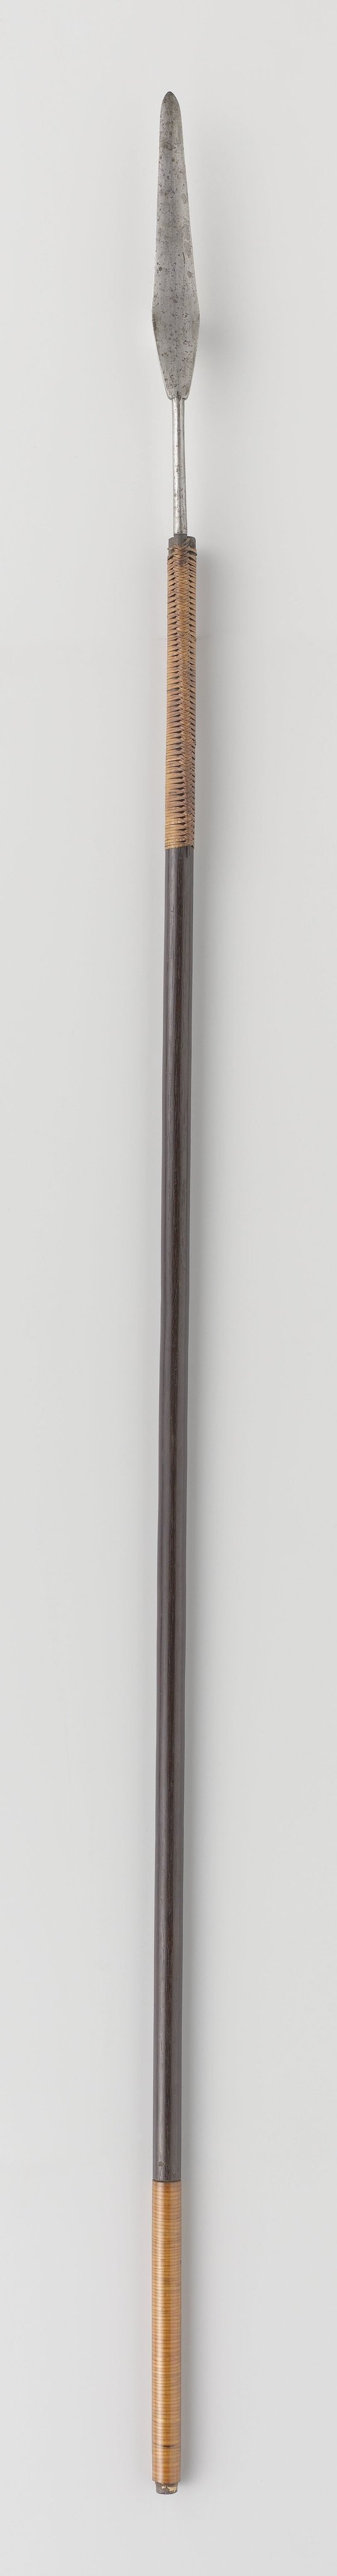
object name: pike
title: Lans uit het wapenrek van Gouverneur-Generaal J.C. baron Baud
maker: Anonymous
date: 1800-1900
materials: iron, paint, wood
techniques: braiding, cutting, forging, painting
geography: kalimantan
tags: the hague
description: Holle zwartgeverfde houten schacht, waarop smalle kling uitlopend in een scherpe punt. De kling is met fijngevlochten riet aan de schacht bevestigd. De basis van de kling heeft kleine puntvormige uitsteeksels. Onderaan de schacht zit een handvat van gevernist riet.